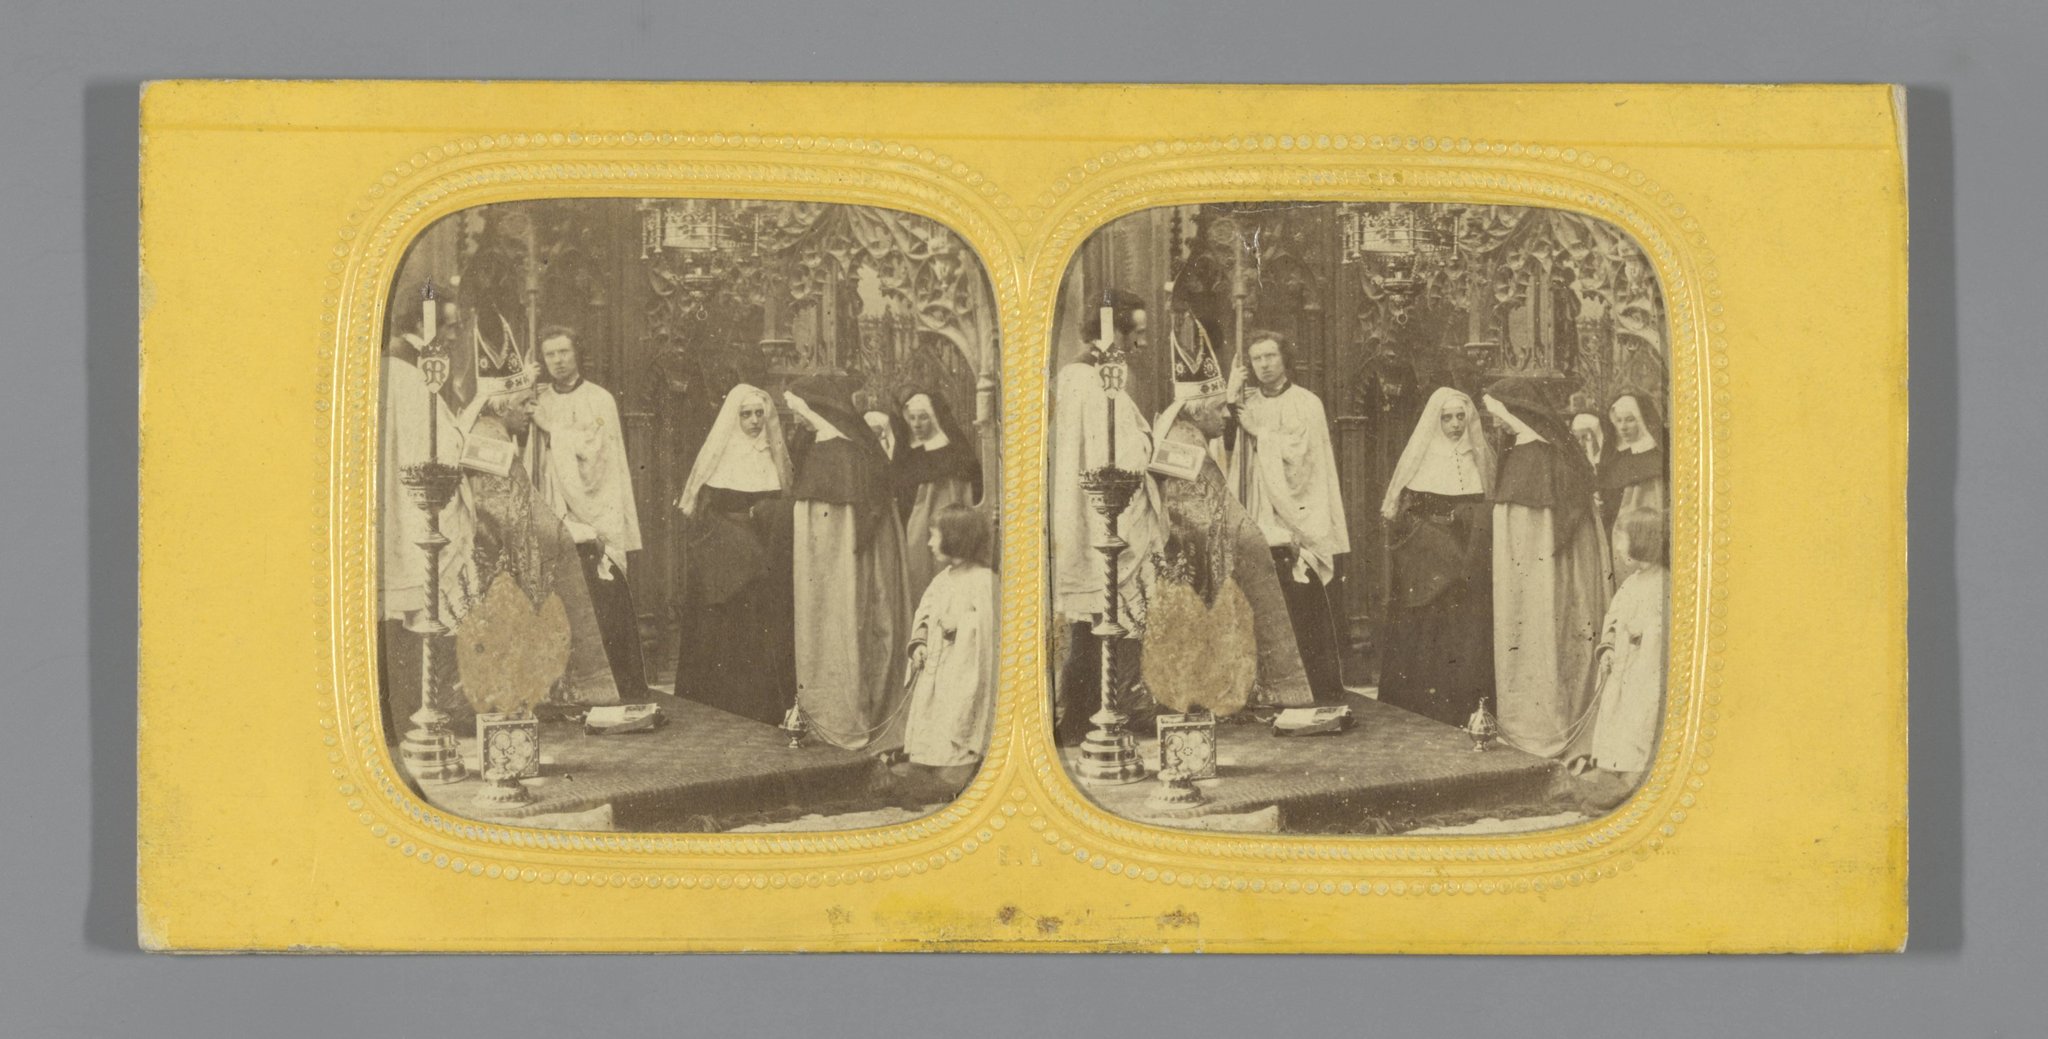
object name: tissue stereograph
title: Nonnen staande voor bisschop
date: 1855-1875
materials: cardboard, paper, photographic support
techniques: albumen print, cutting, hand coloring, perforating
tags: archbishop, bishop, etc. (roman catholic), nun(s)